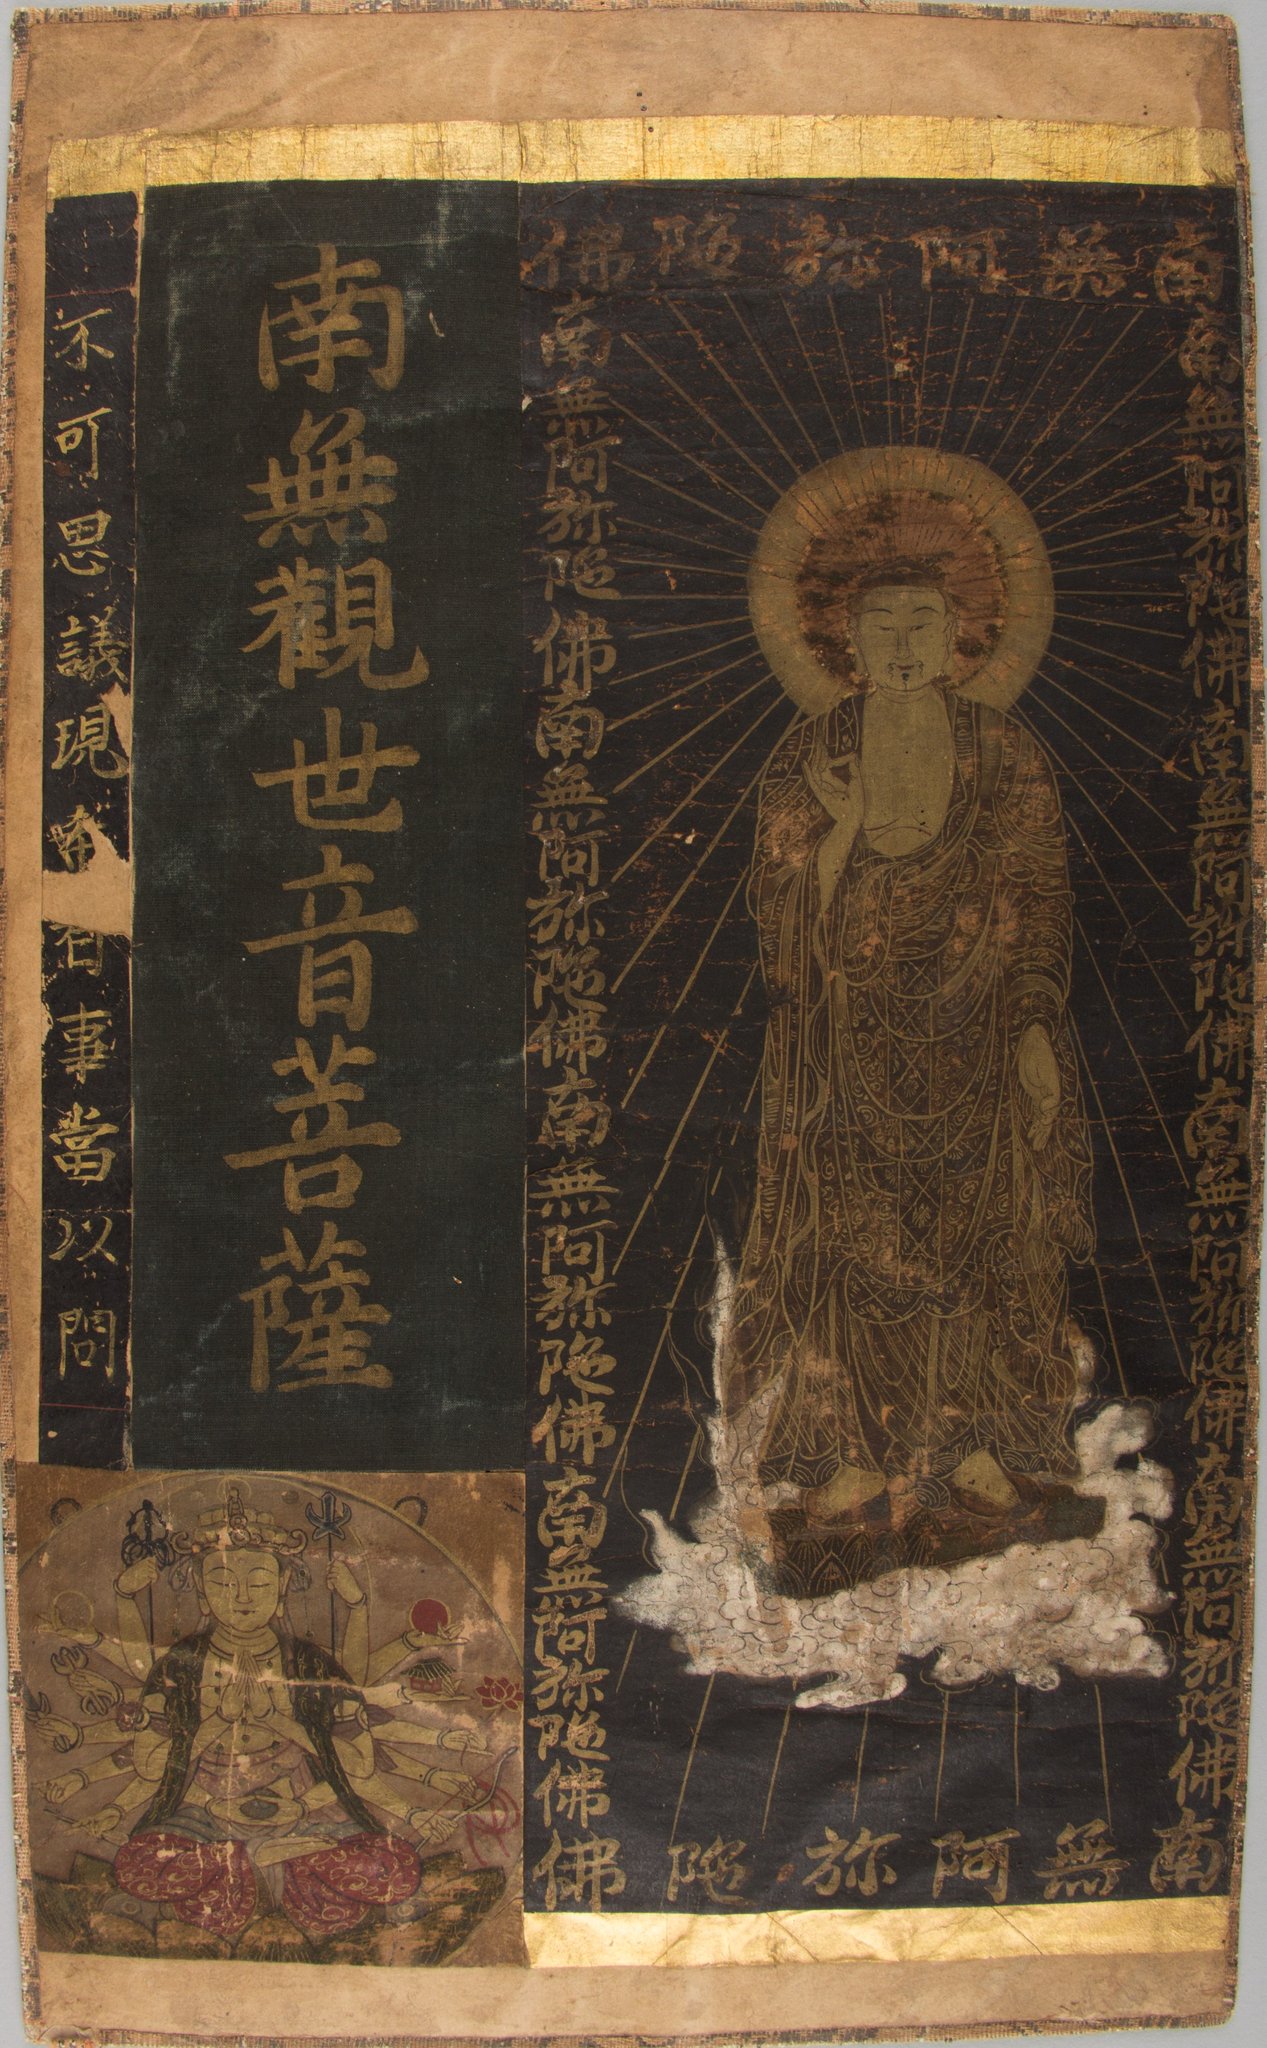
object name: book fragment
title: Page of a Pilgrim’s Visiting Album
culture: japanese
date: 1767-1900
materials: gold, ink, paper, textile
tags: buddhism,buddha